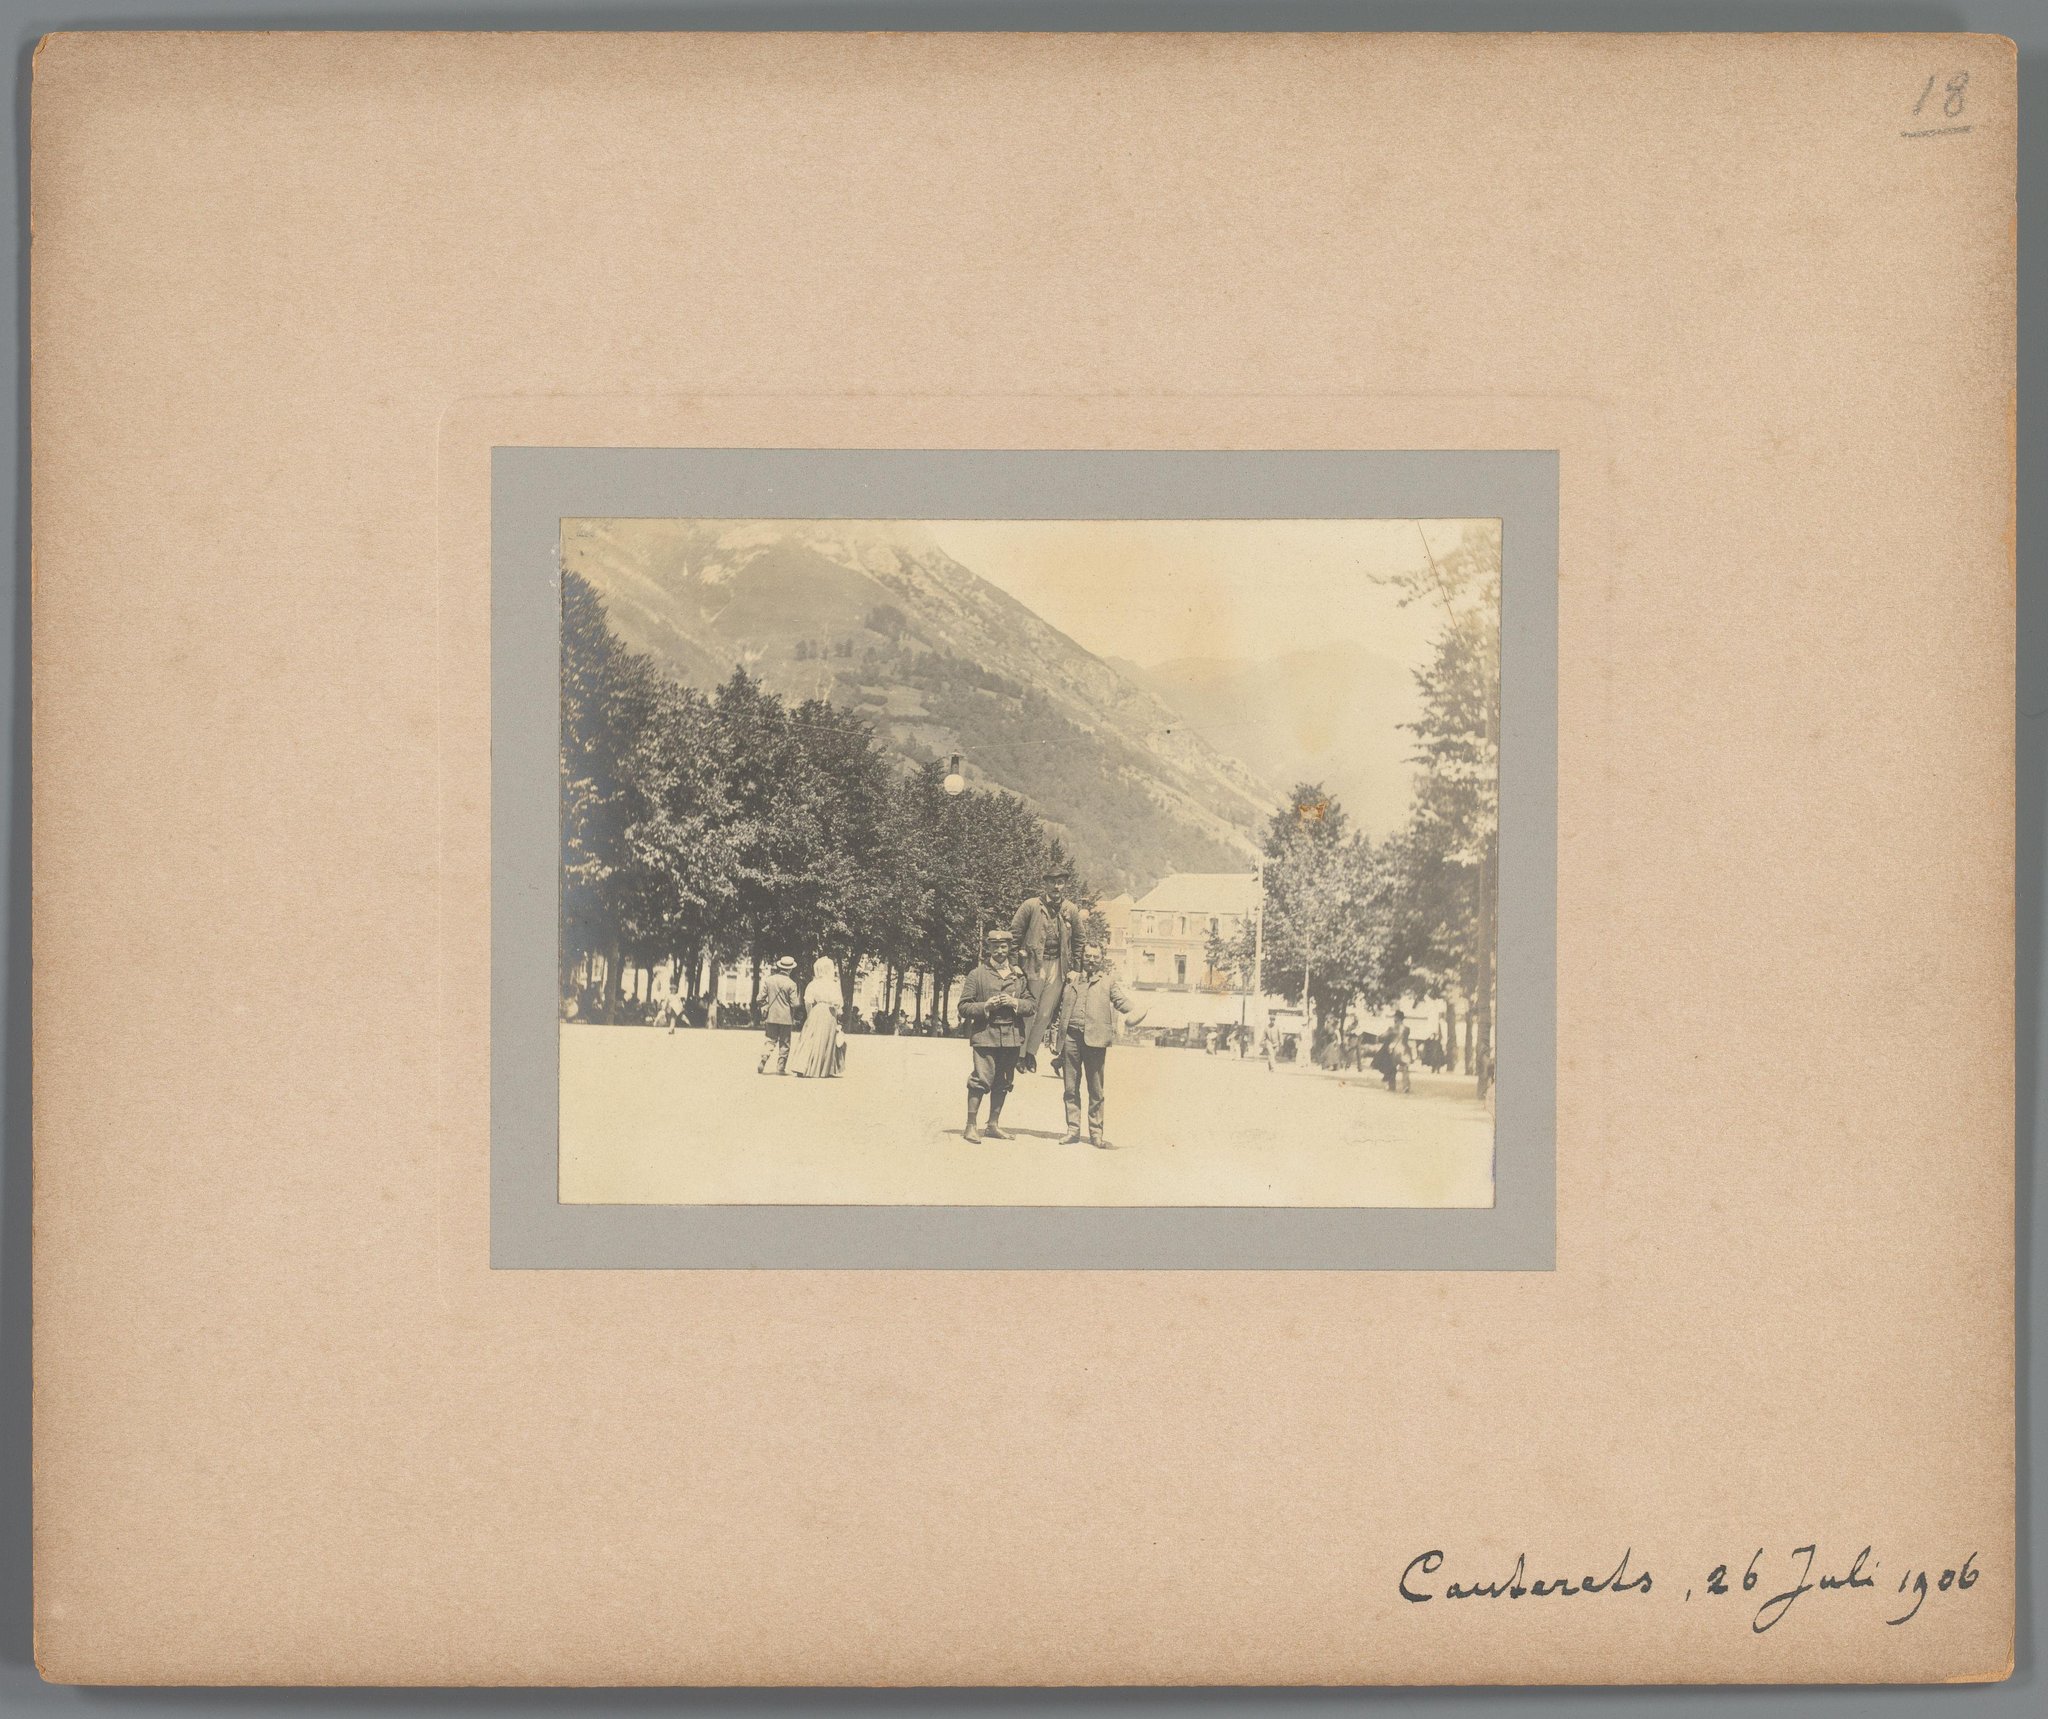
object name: photograph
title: Groepsportret van drie mannen in Cauterets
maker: françois buys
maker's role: advocaat, amateurfotograaf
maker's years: 1871-1934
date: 1906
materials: paper, cardboard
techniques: gelatin silver print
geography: cauterets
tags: square, place, circus, etc., anonymous historical persons portrayed in a group, in a group-portrait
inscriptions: number: ‘18’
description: Deze foto maakt deel uit van een groep van 49 foto's.